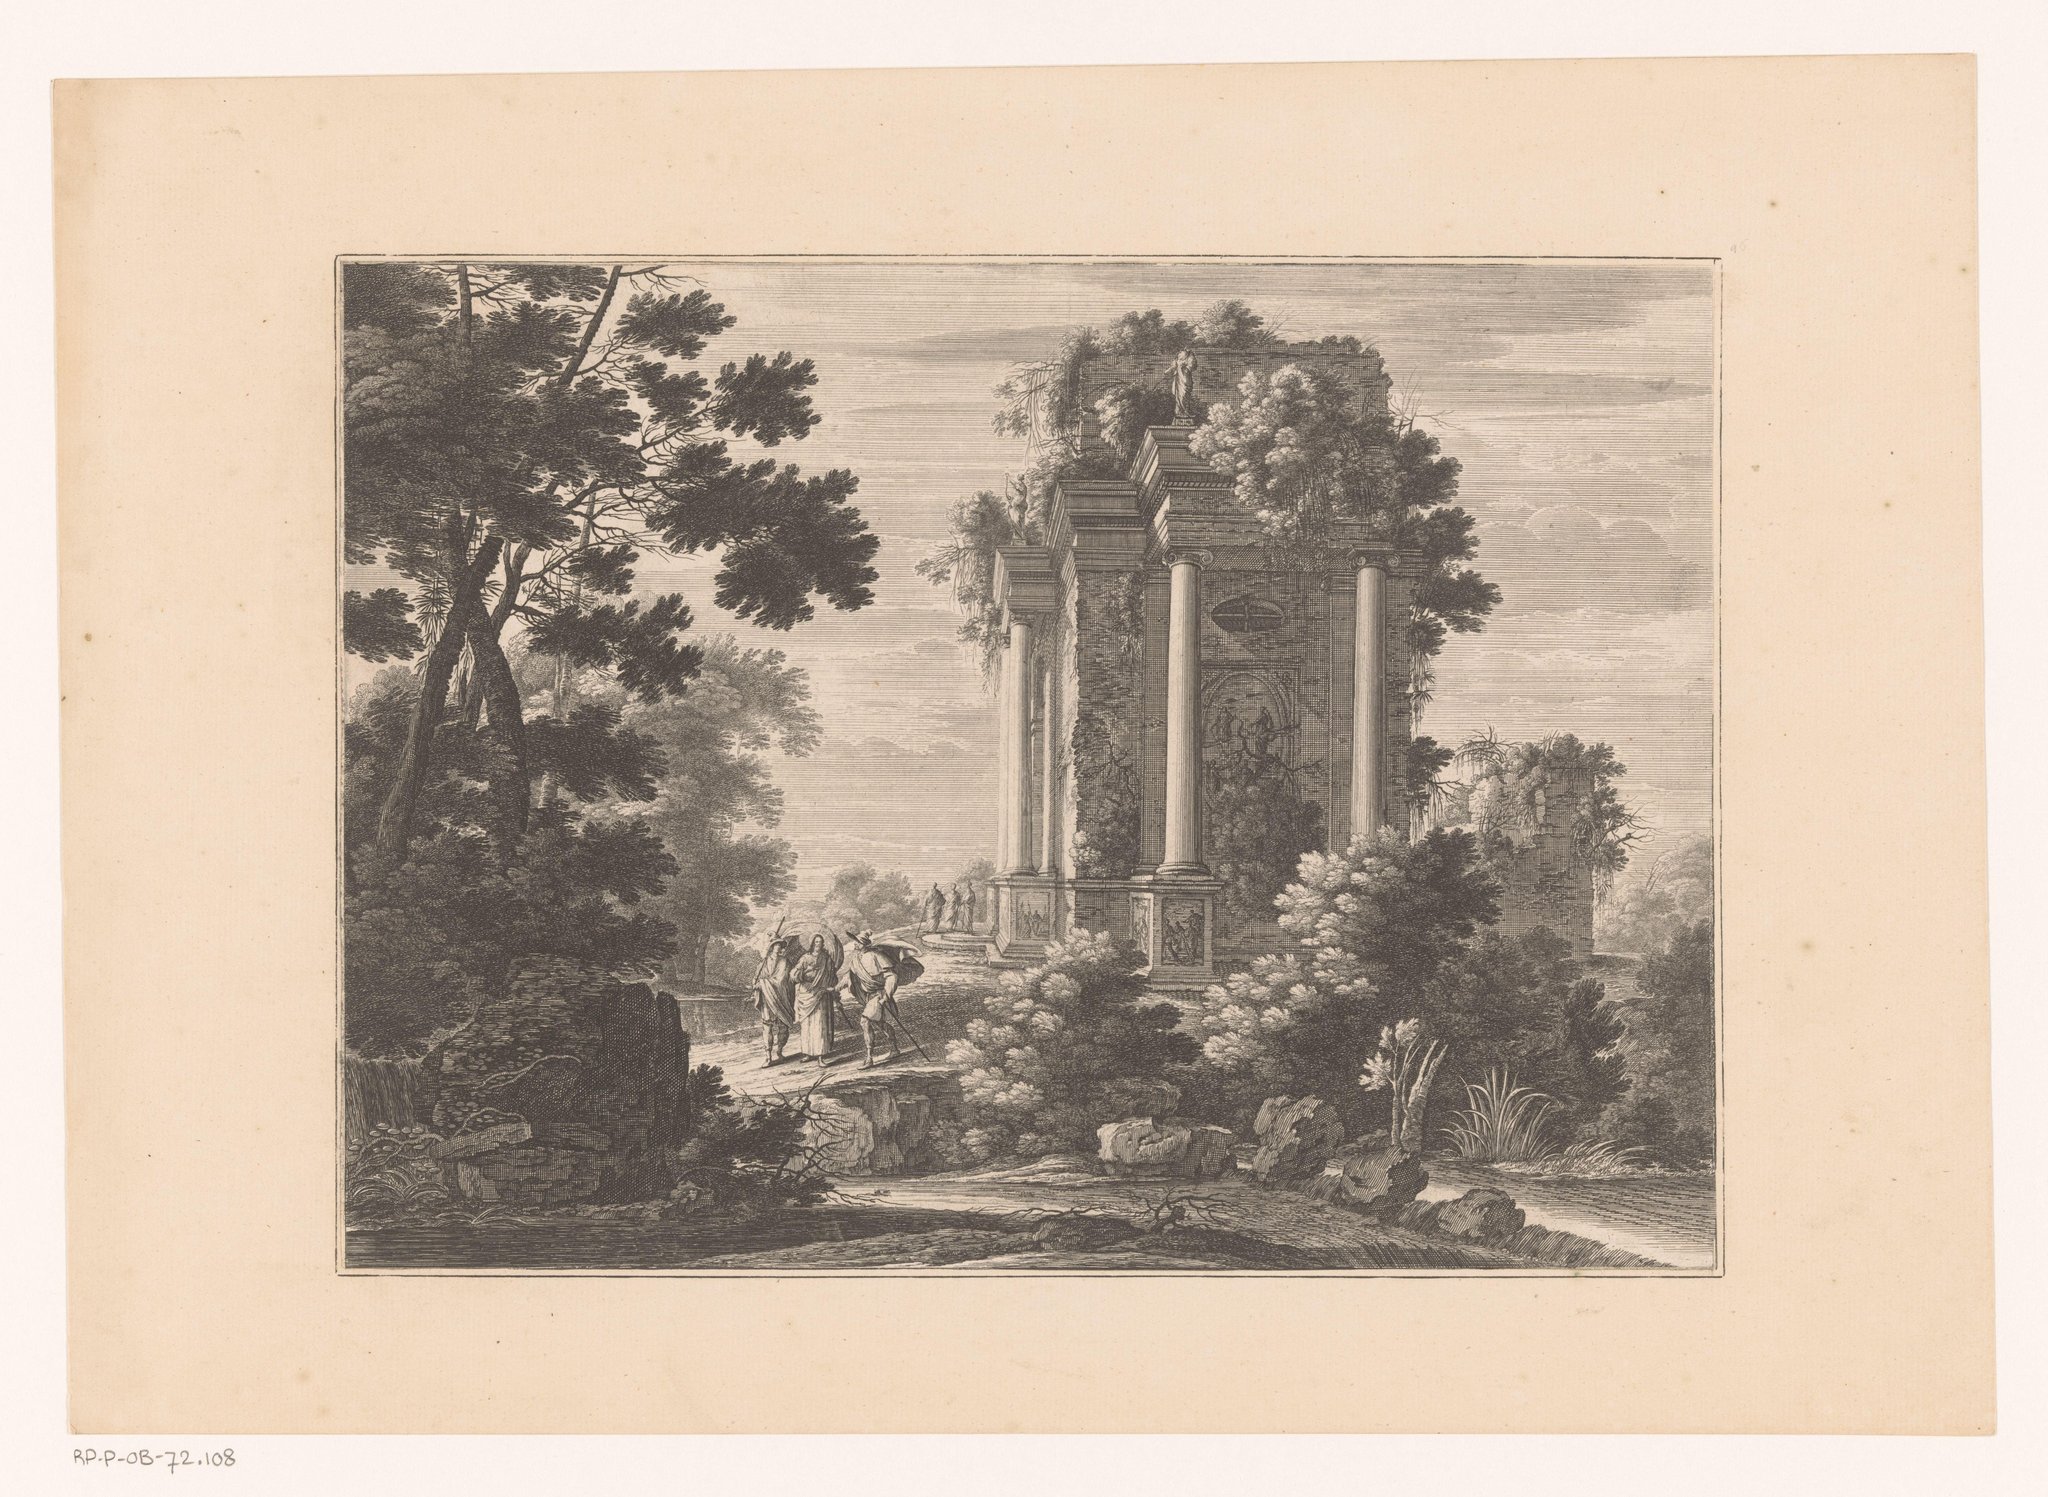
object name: print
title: Landschap met Christus en twee mannen voor antieke ruïne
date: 1613-1695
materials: paper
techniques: engraving, etching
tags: landscape with ruins, christ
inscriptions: collector's mark: Lugt 240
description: Prenten met het signatuur 'Perelle' kunnen zowel door vader Gabriel als door zonen Nicolas en Adam gemaakt zijn.